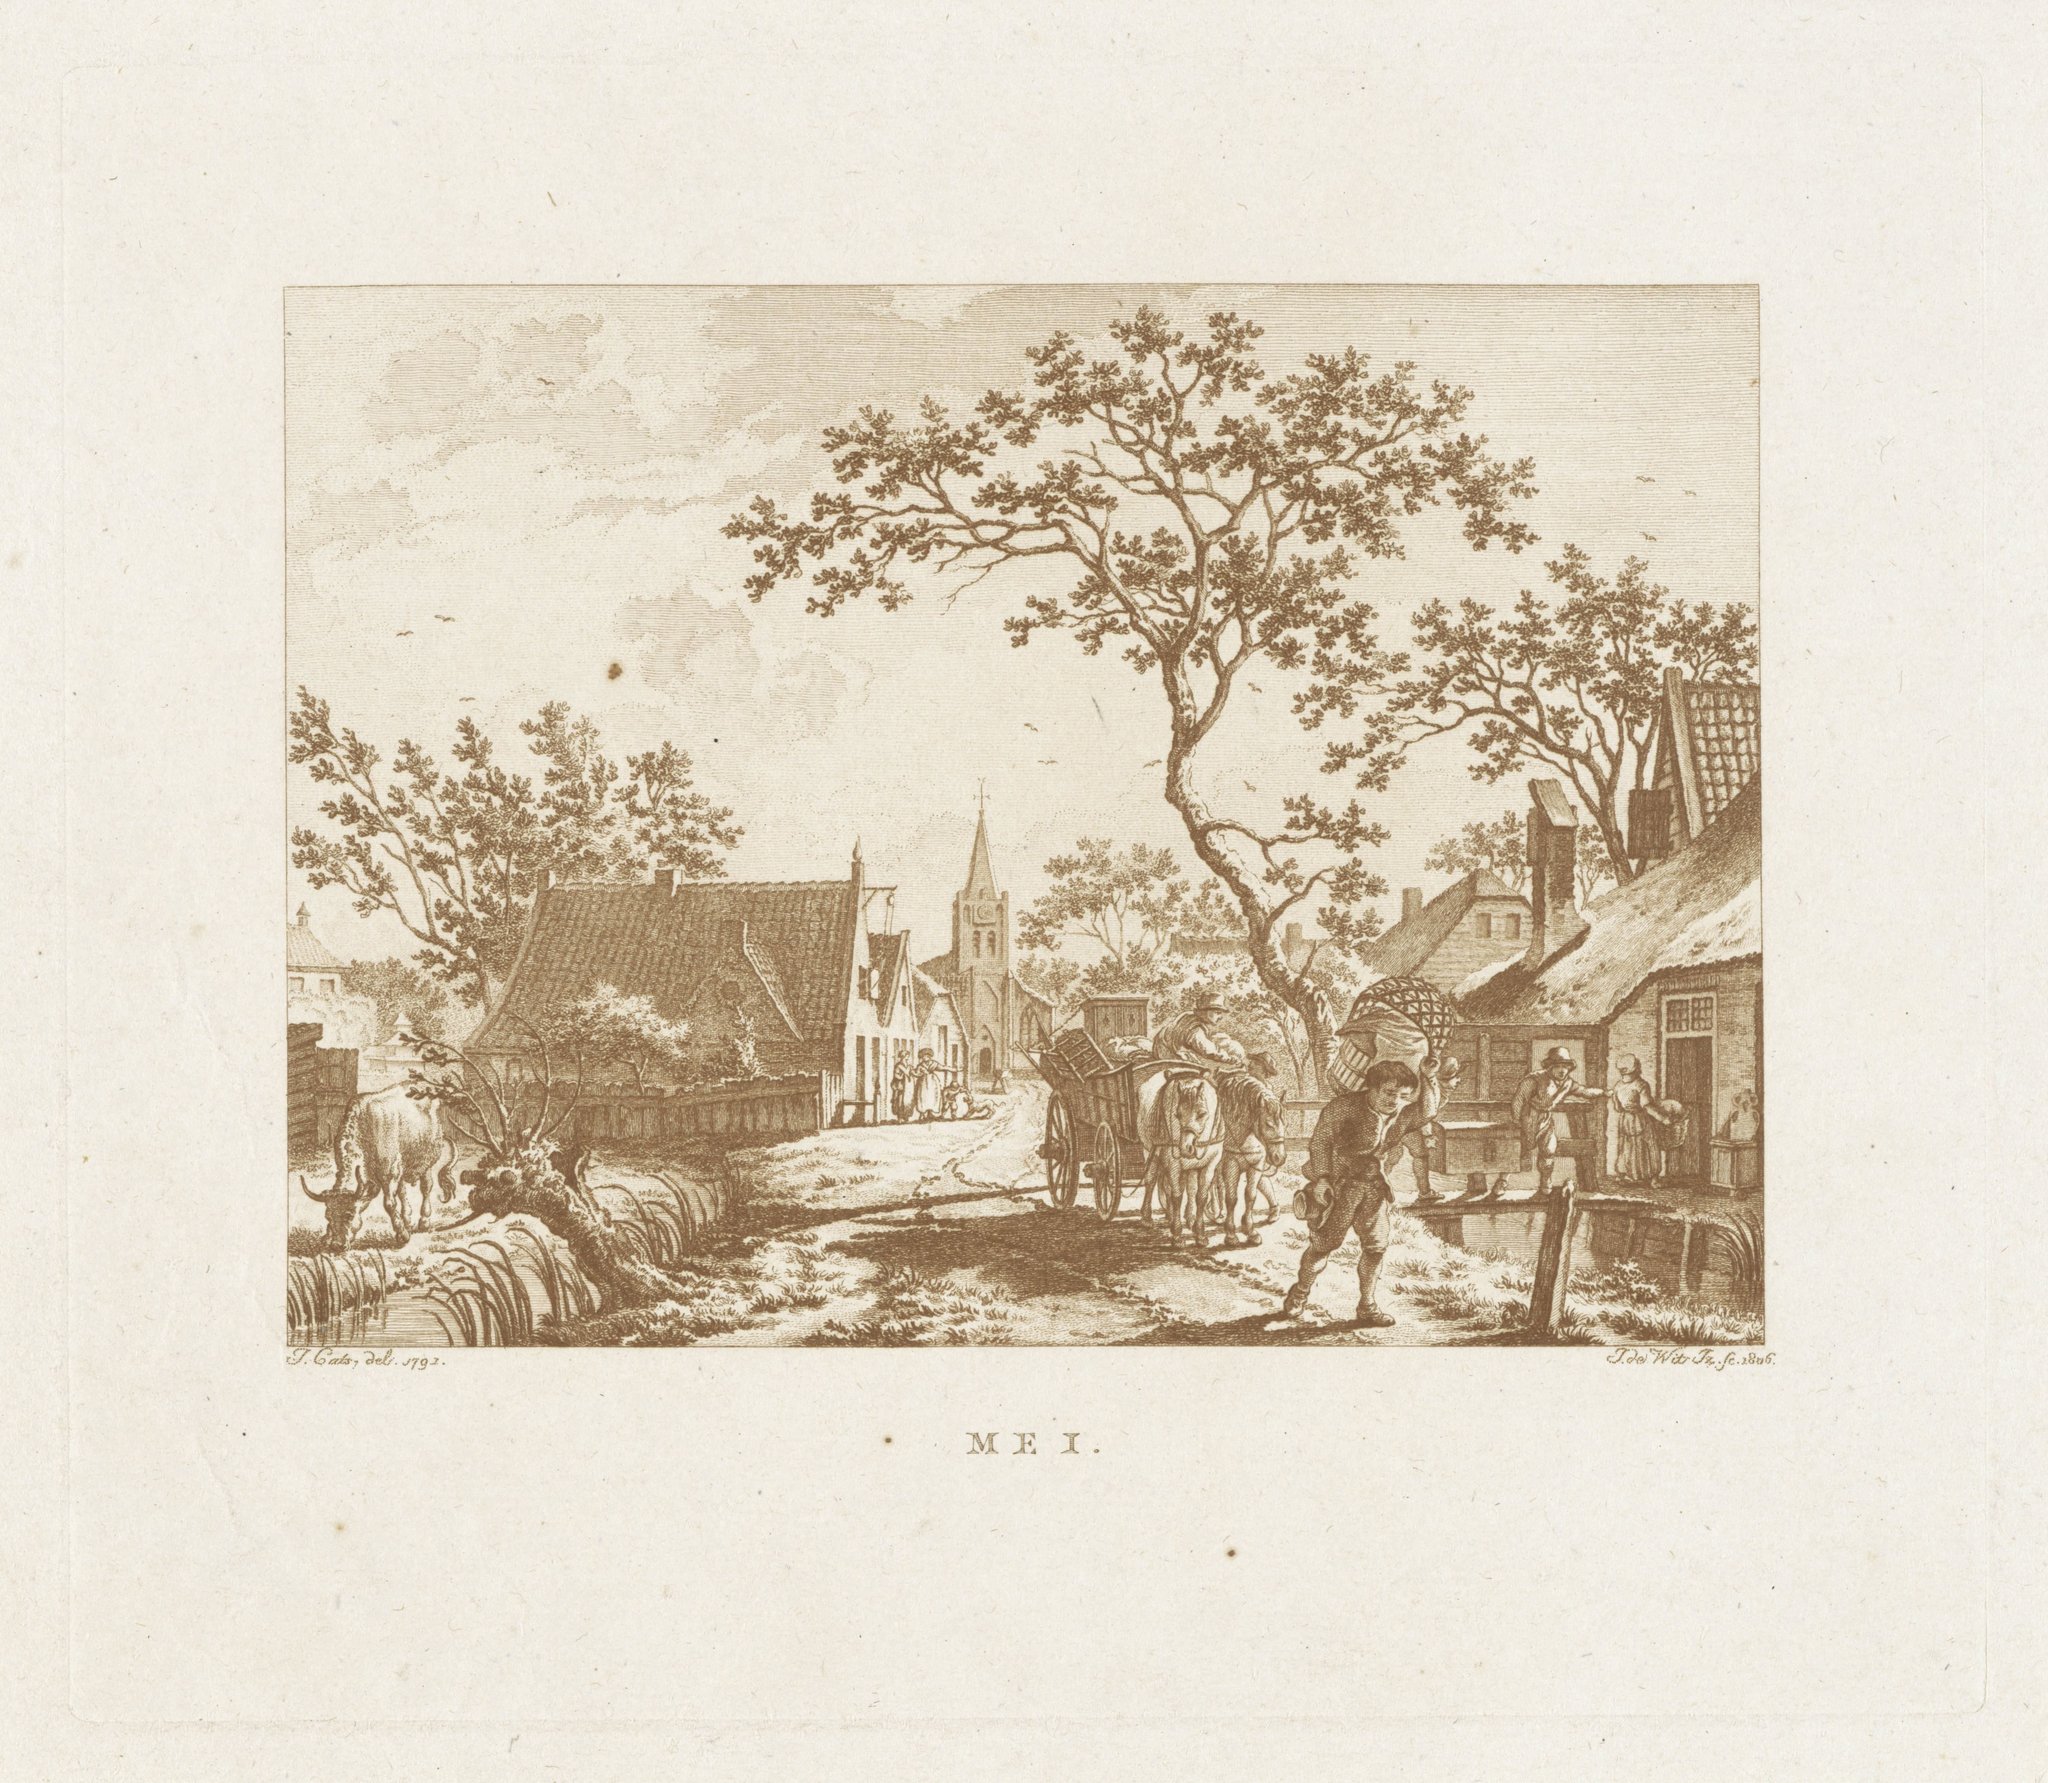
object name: print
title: Figuren met huisraad in een dorpsstraat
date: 1806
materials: paper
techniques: etching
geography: haarlem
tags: may and its 'labours' (+ with scenes showing human occupations ~ seasons and months), village street, (farm) wagon, freight wagon, cart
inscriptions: collector's mark: Lugt 2228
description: Gezicht in een dorp met een verhuizing. De meubels en kisten worden van een kar met twee paarden ervoor geladen en een huis binnengedragen. Op de voorgrond een man met mand op de rug.